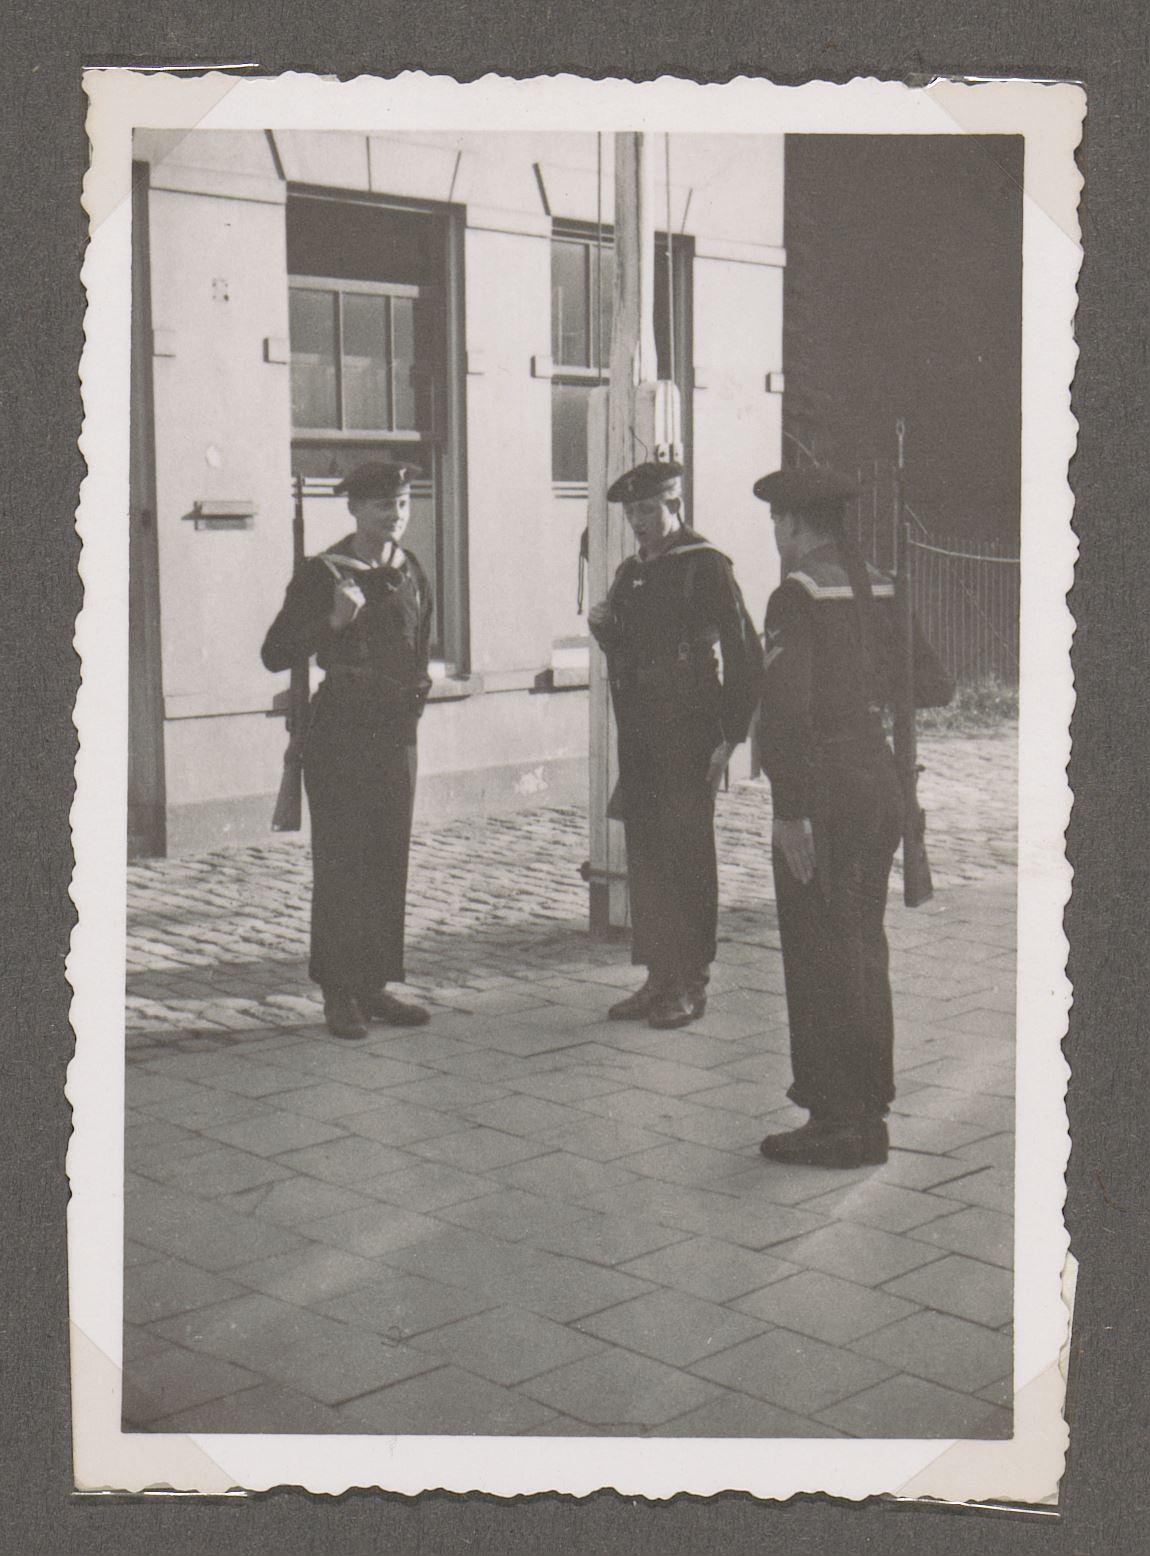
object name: photograph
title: Drie militairen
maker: Anonymous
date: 1941-1945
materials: paper, photographic support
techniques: gelatin silver print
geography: netherlands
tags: the soldier; the soldier's life, netherlands